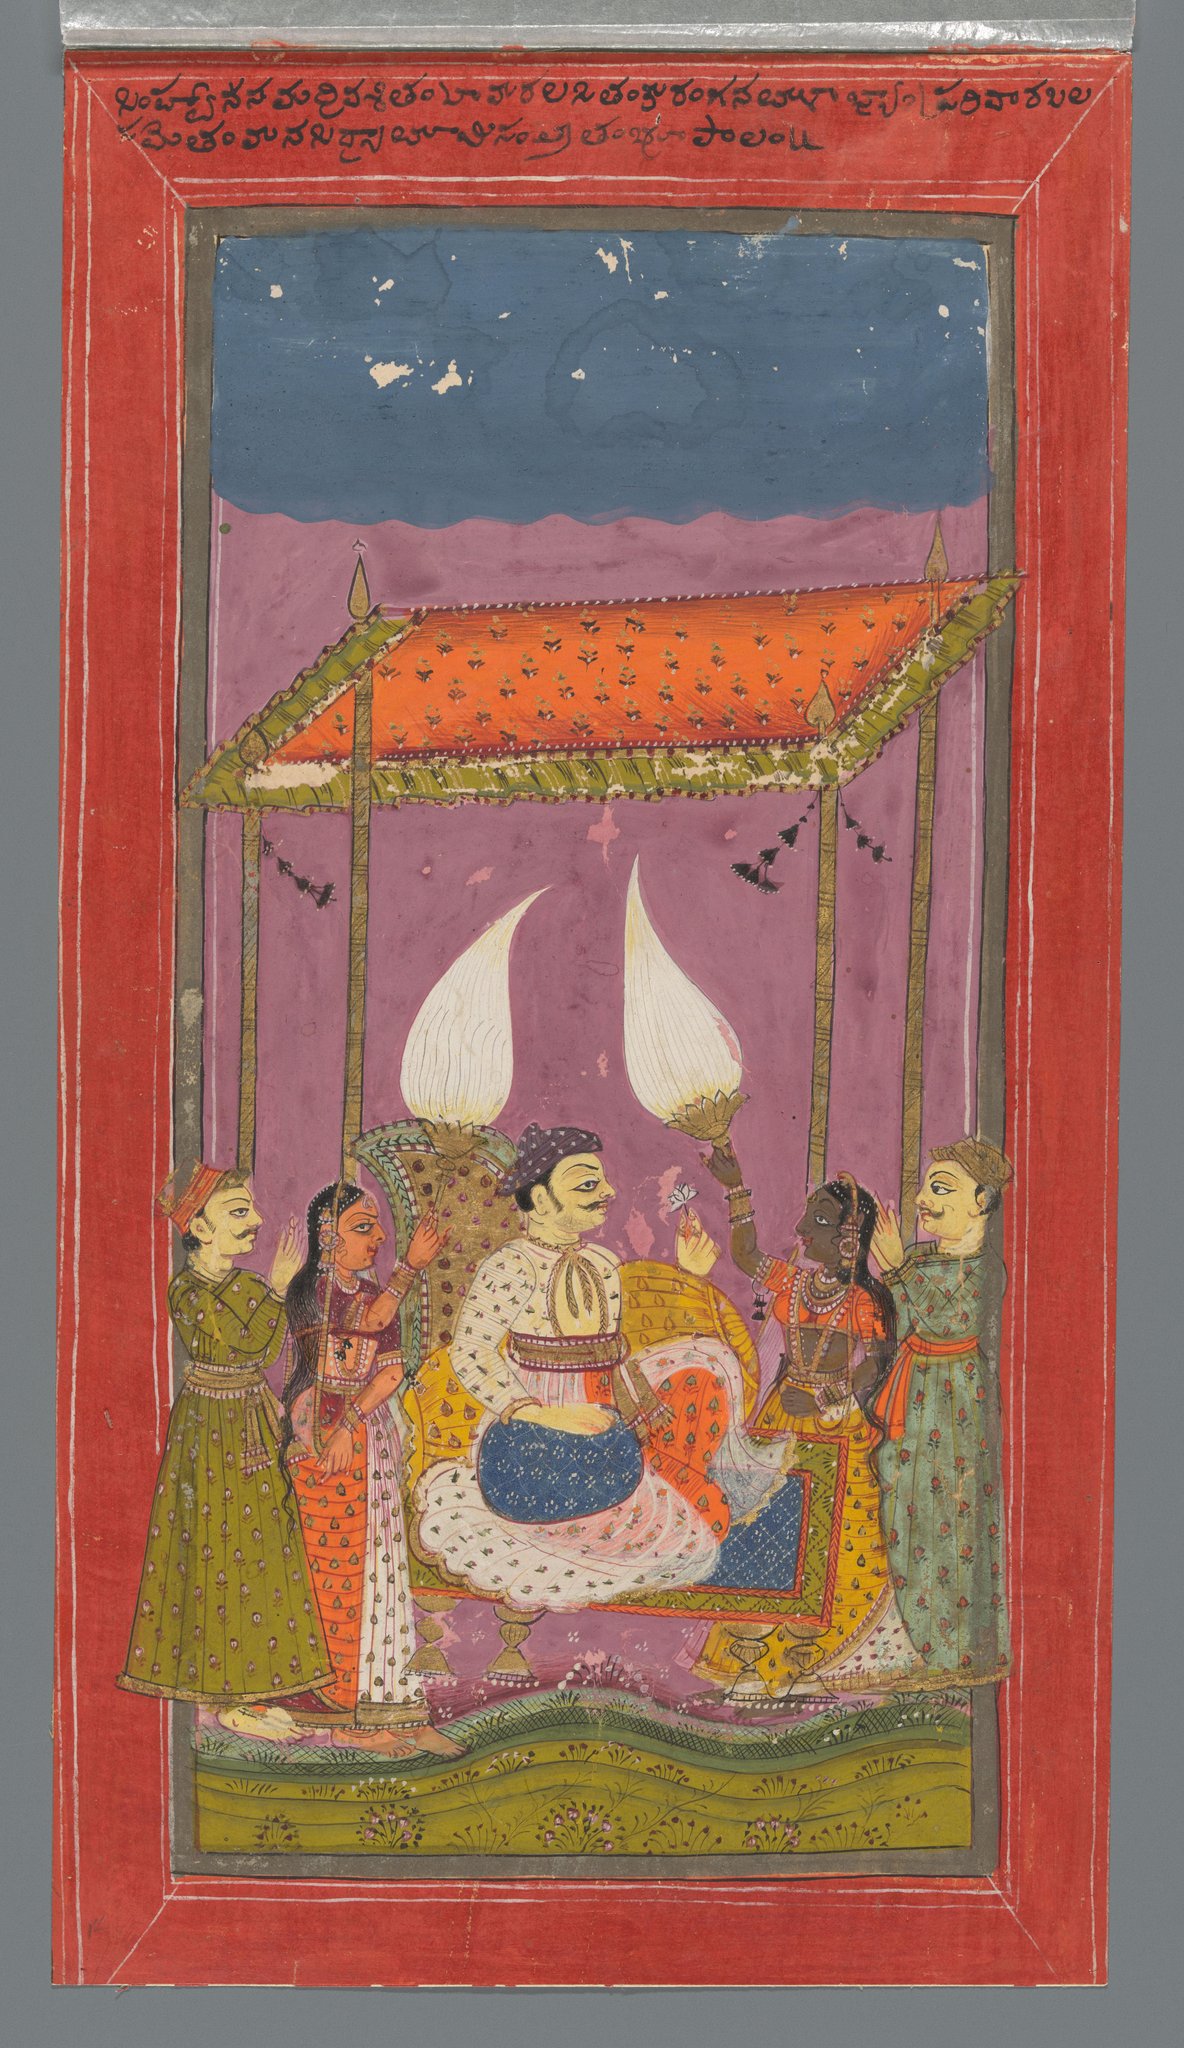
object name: indian miniature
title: Ragamala painting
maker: Anonymous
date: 1750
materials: paper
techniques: brush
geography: wanaparthy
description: Bhupala raga. A royal figure seated on a cushioned throne, holding a flower. He is flanked by yaktail whisks (chamara)-bearing ladies and courtiers. At the top of the frame there are verses from the unpublished Sanskrit poem Ragasagara (c. 17th century with later additions), written here in Telugu script.